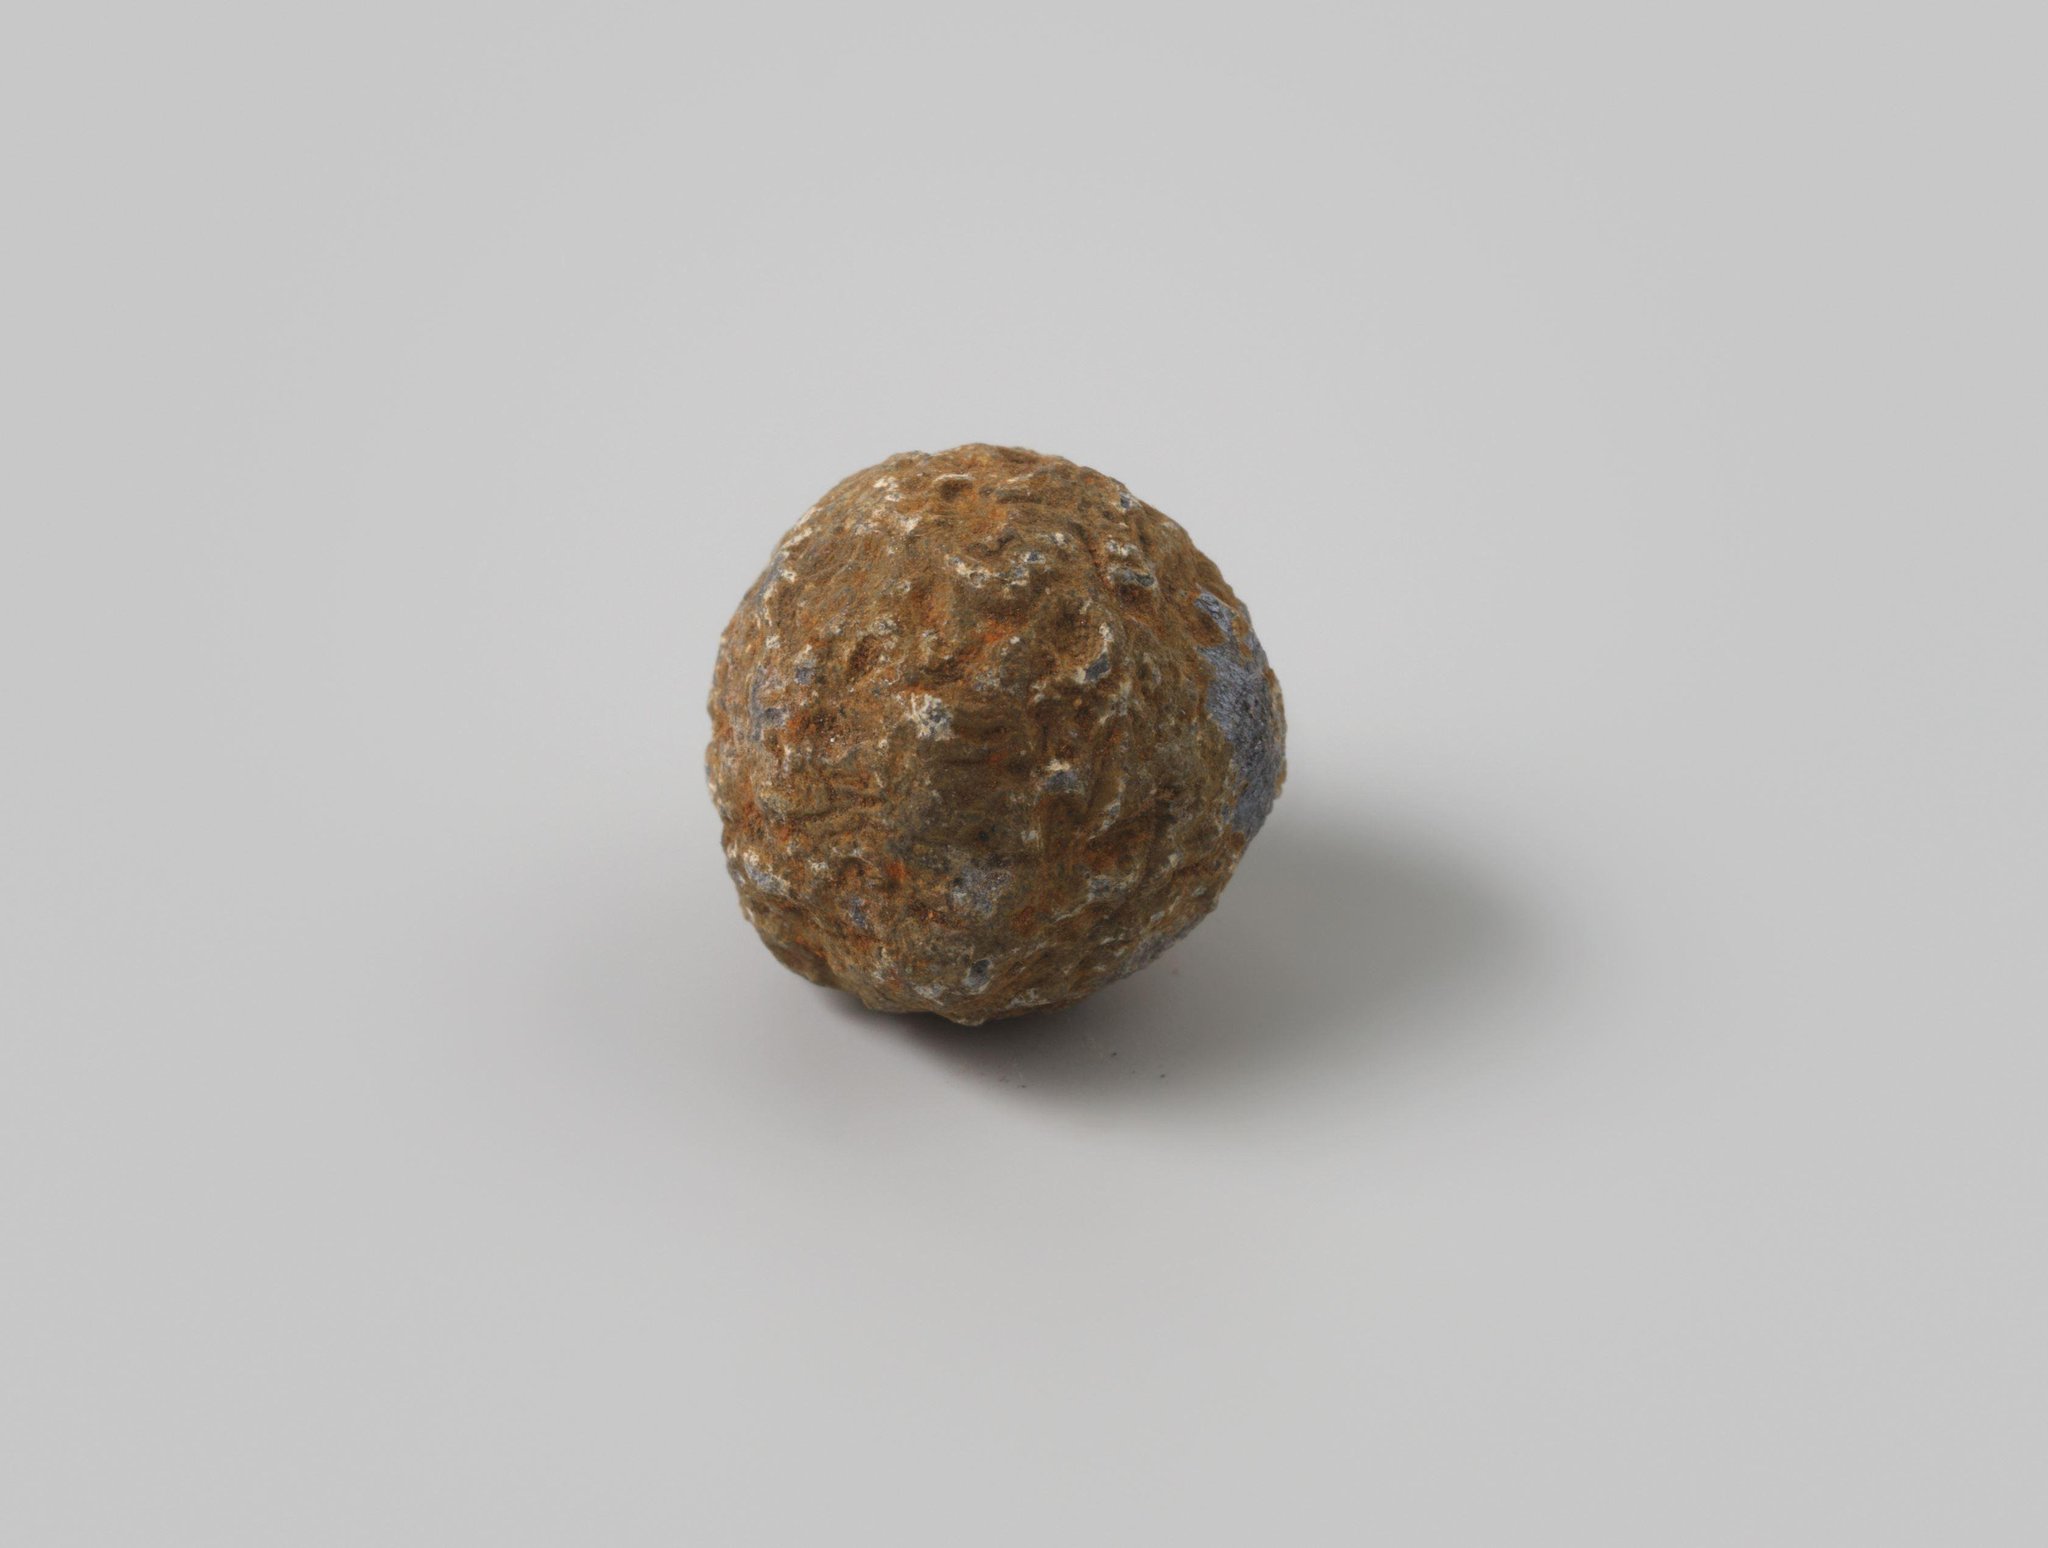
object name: bullet ammunition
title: Kogel uit het wrak van de Oost-Indiëvaarder Hollandia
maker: Anonymous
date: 1700-1743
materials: lead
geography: netherlands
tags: verenigde oostindische compagnie, hollandia (schip), annet